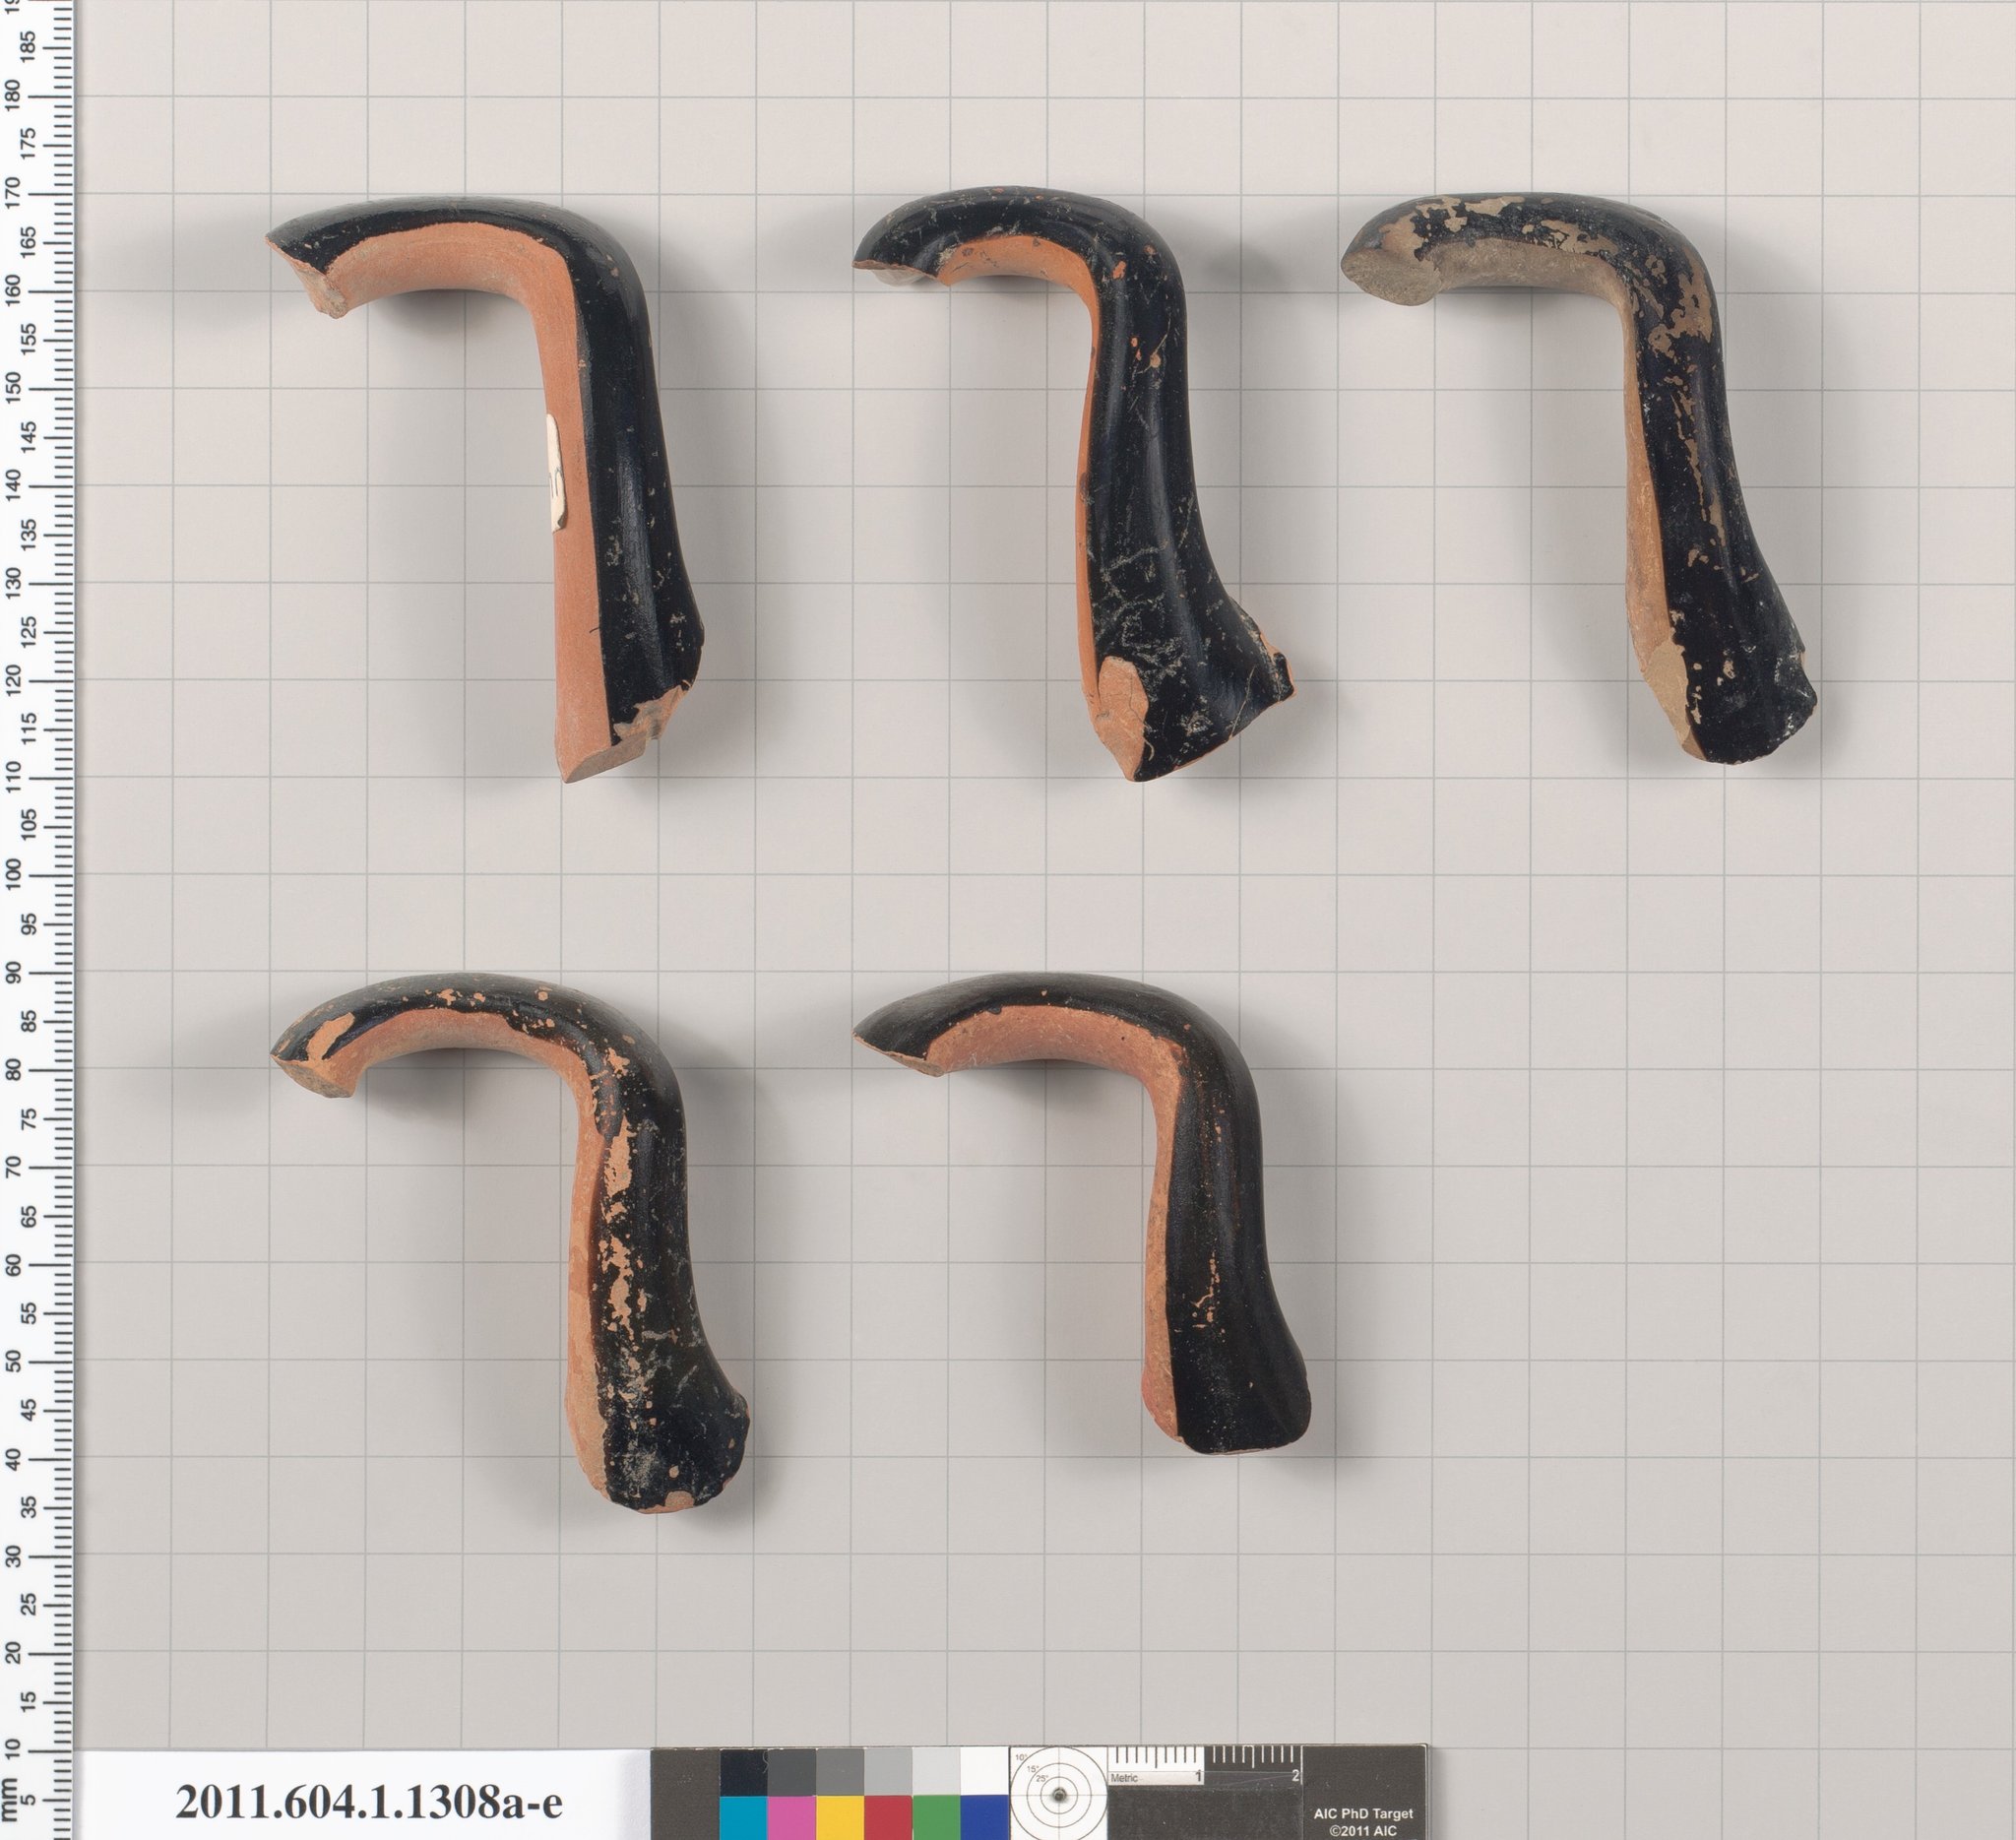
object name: kylix fragment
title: Terracotta fragments of kylikes (drinking cups)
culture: greek, attic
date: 500-401 BCE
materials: terracotta